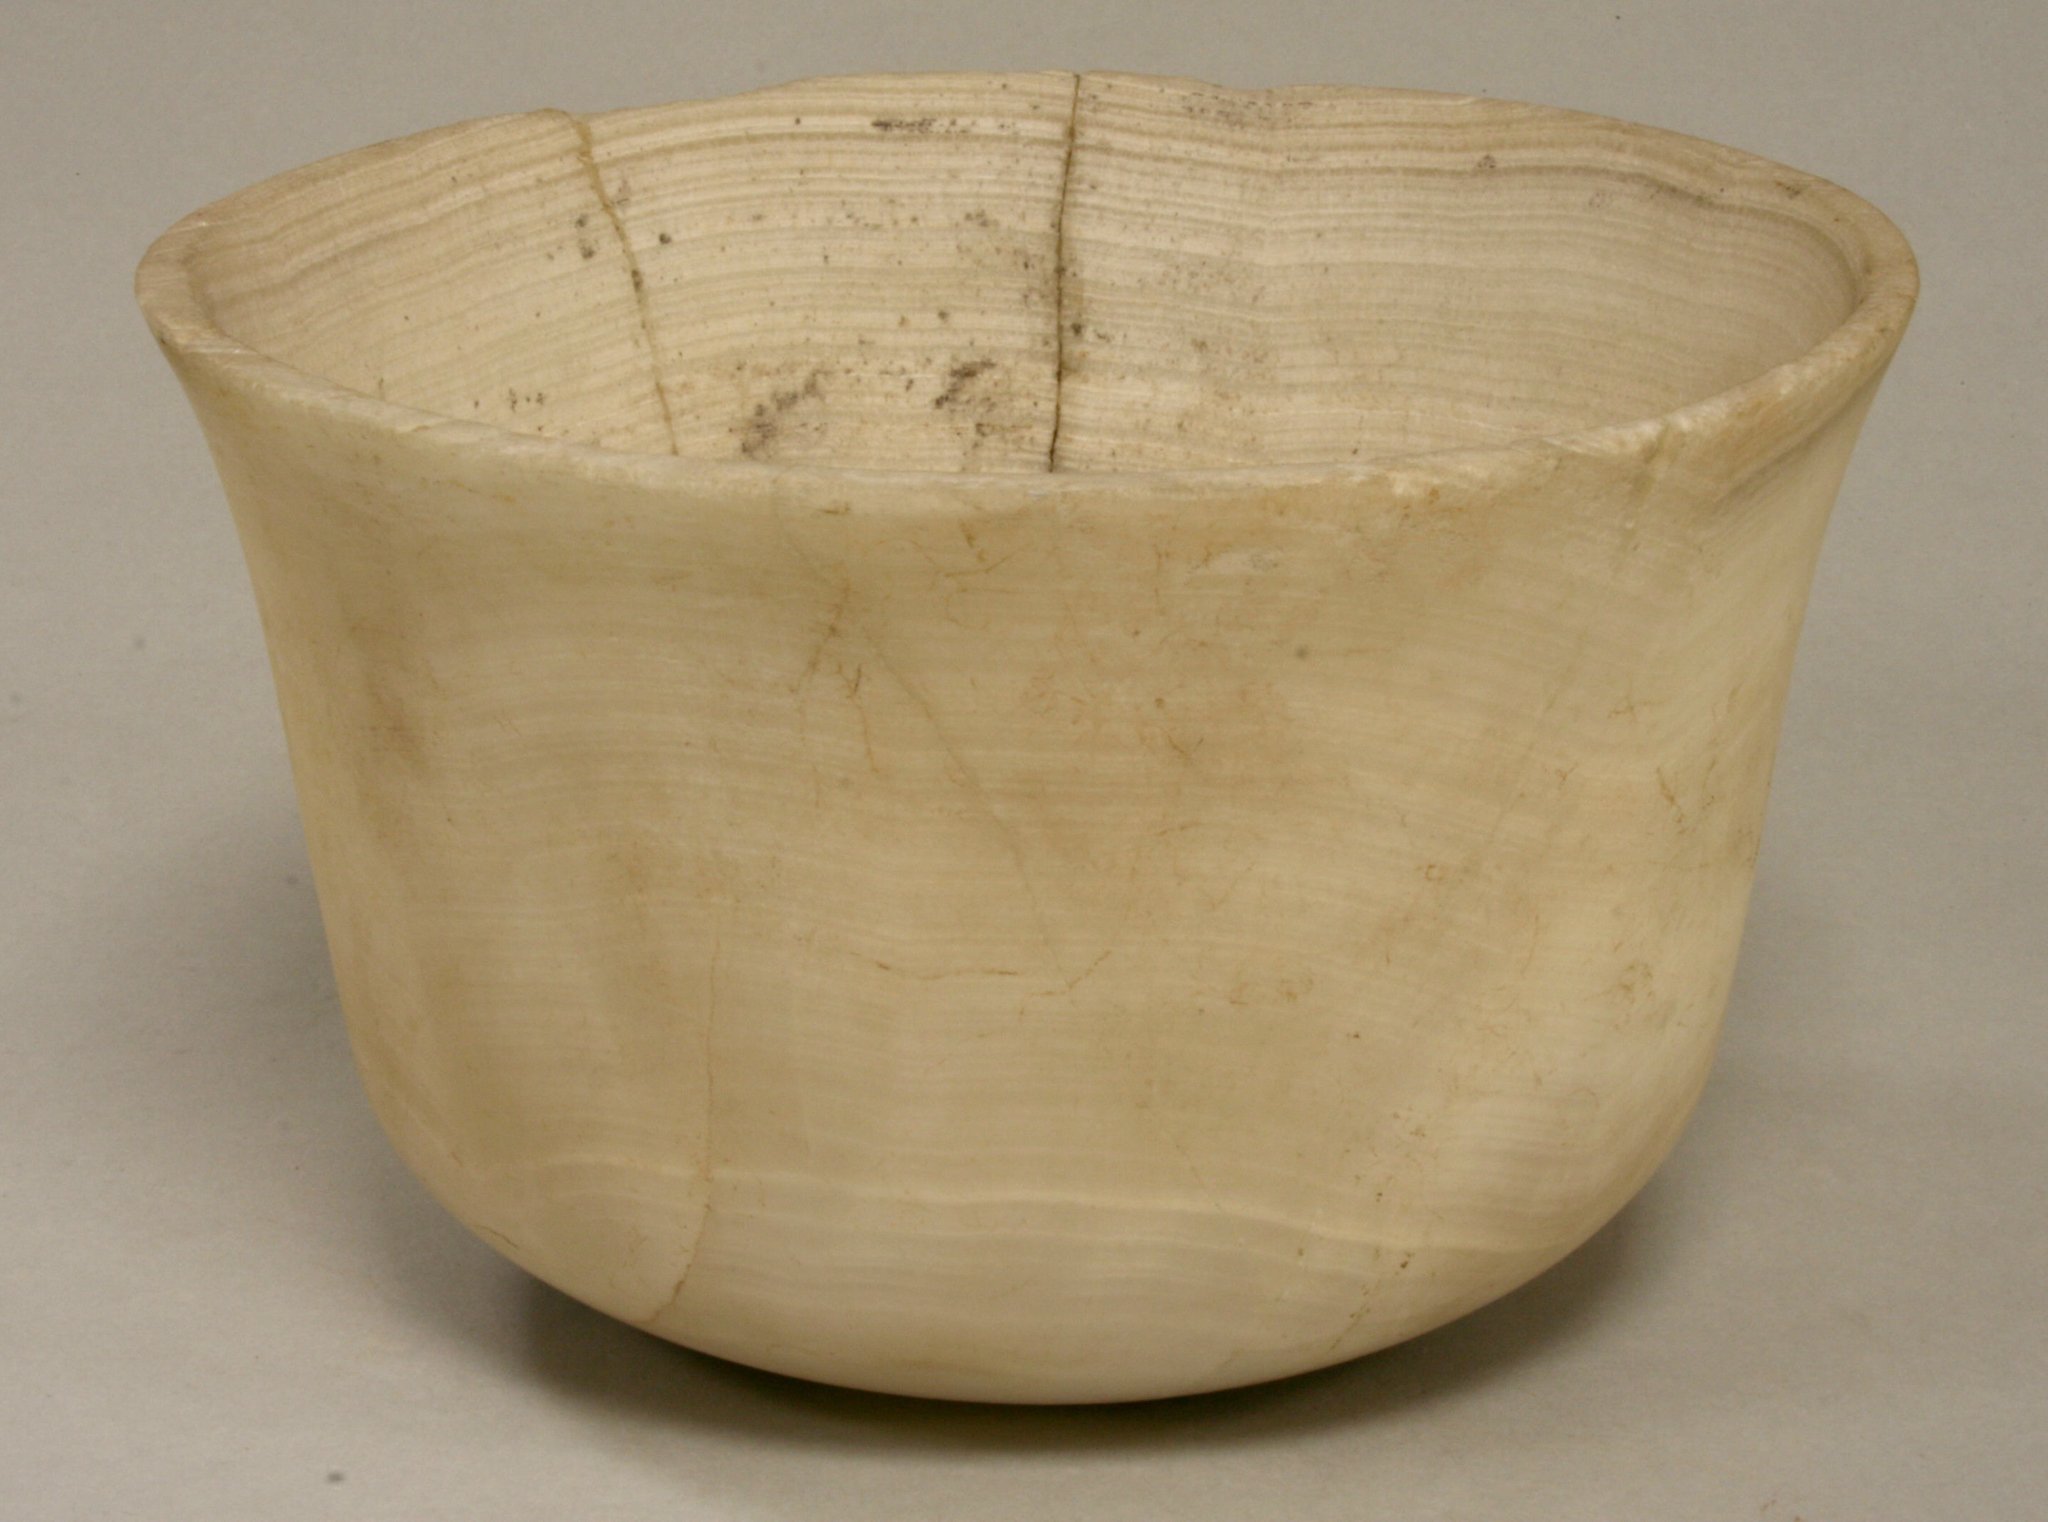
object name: bowl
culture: mexican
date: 901-1500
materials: marble, onyx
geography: mexico